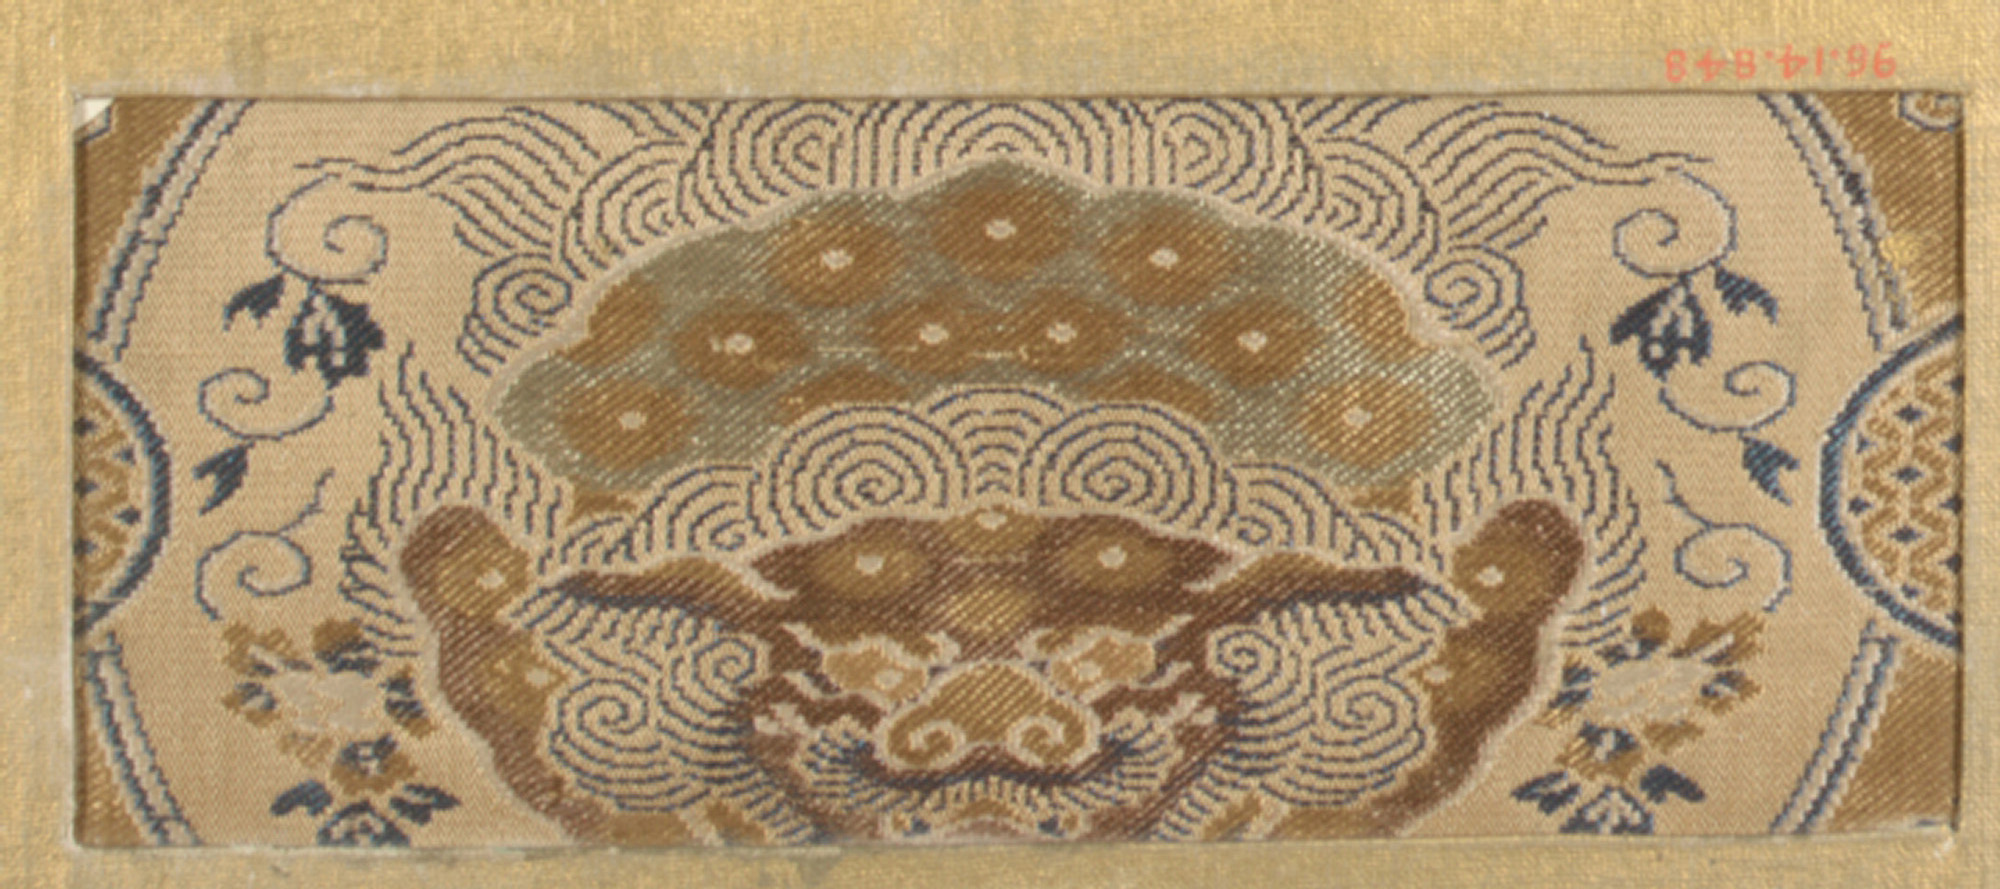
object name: piece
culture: japanese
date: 1701-1900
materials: silk